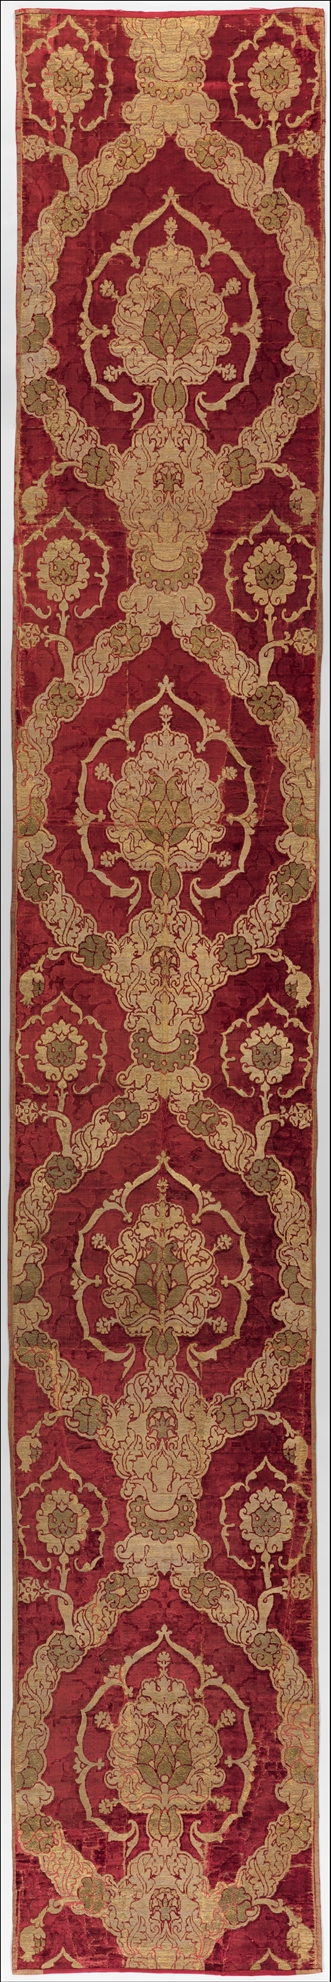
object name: length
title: Length of velvet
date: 1467-1500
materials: metal thread, silk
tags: flowers